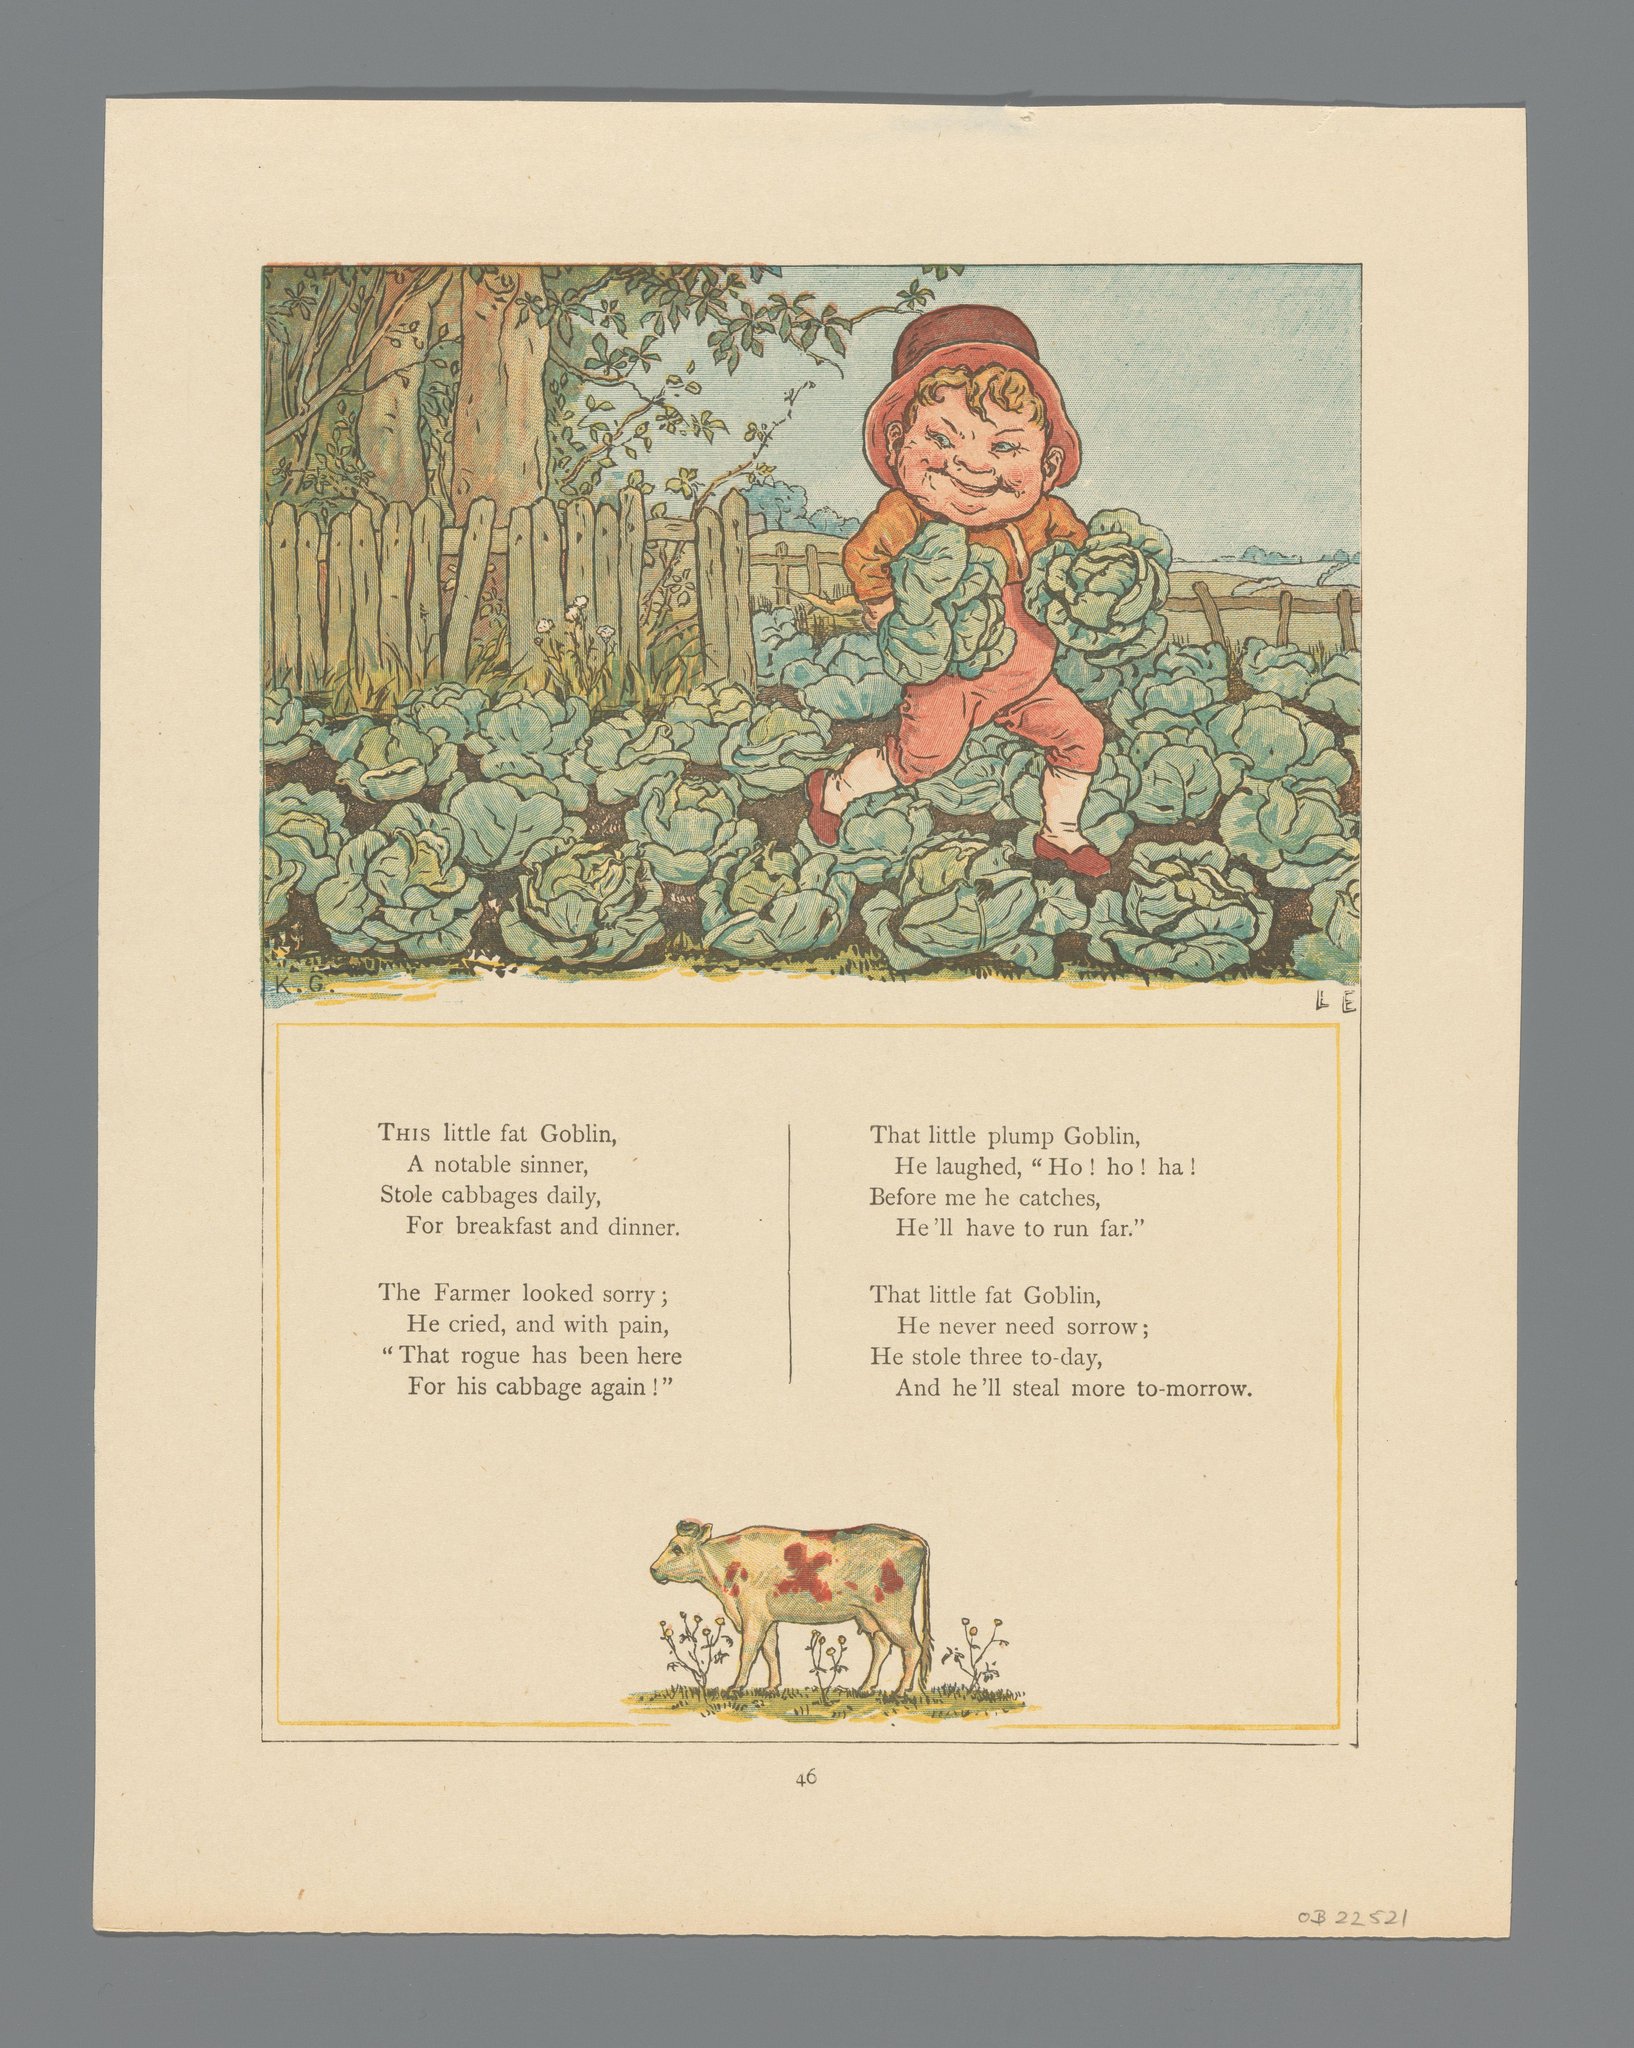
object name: print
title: Aardman steelt twee kolen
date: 1878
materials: paper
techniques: wood engraving, letterpress printing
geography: london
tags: theft, plants and herbs: cabbage, goblins, hobgoblins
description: Prent uit: Greenaway, Kate. Under the window, pictures & rhymes for children. Londen: George Routledge & Sons, 1878, p. 46.